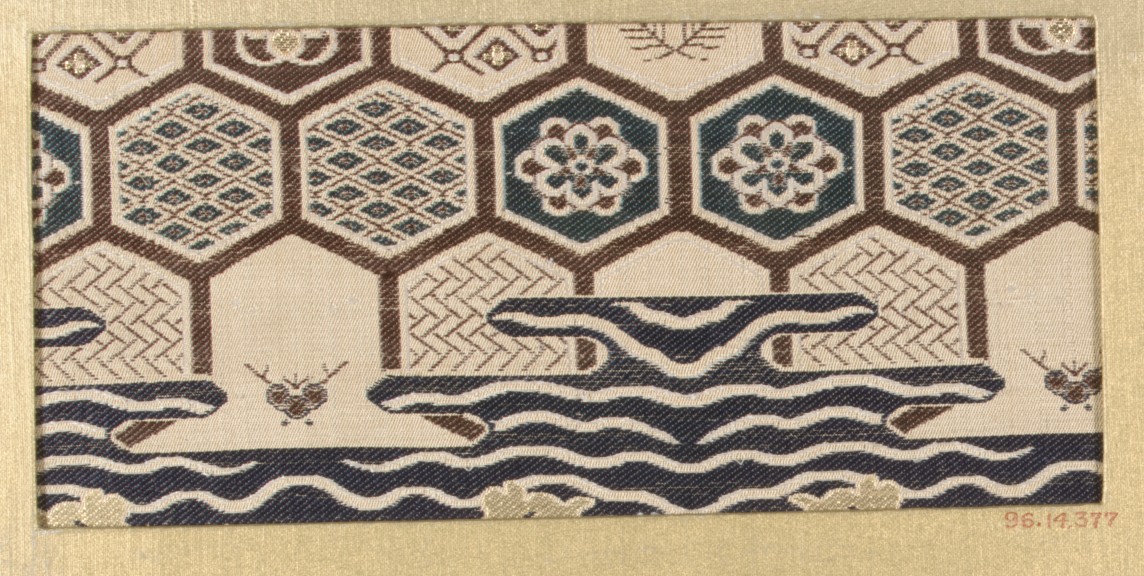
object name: piece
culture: japanese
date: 1701-1900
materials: silk